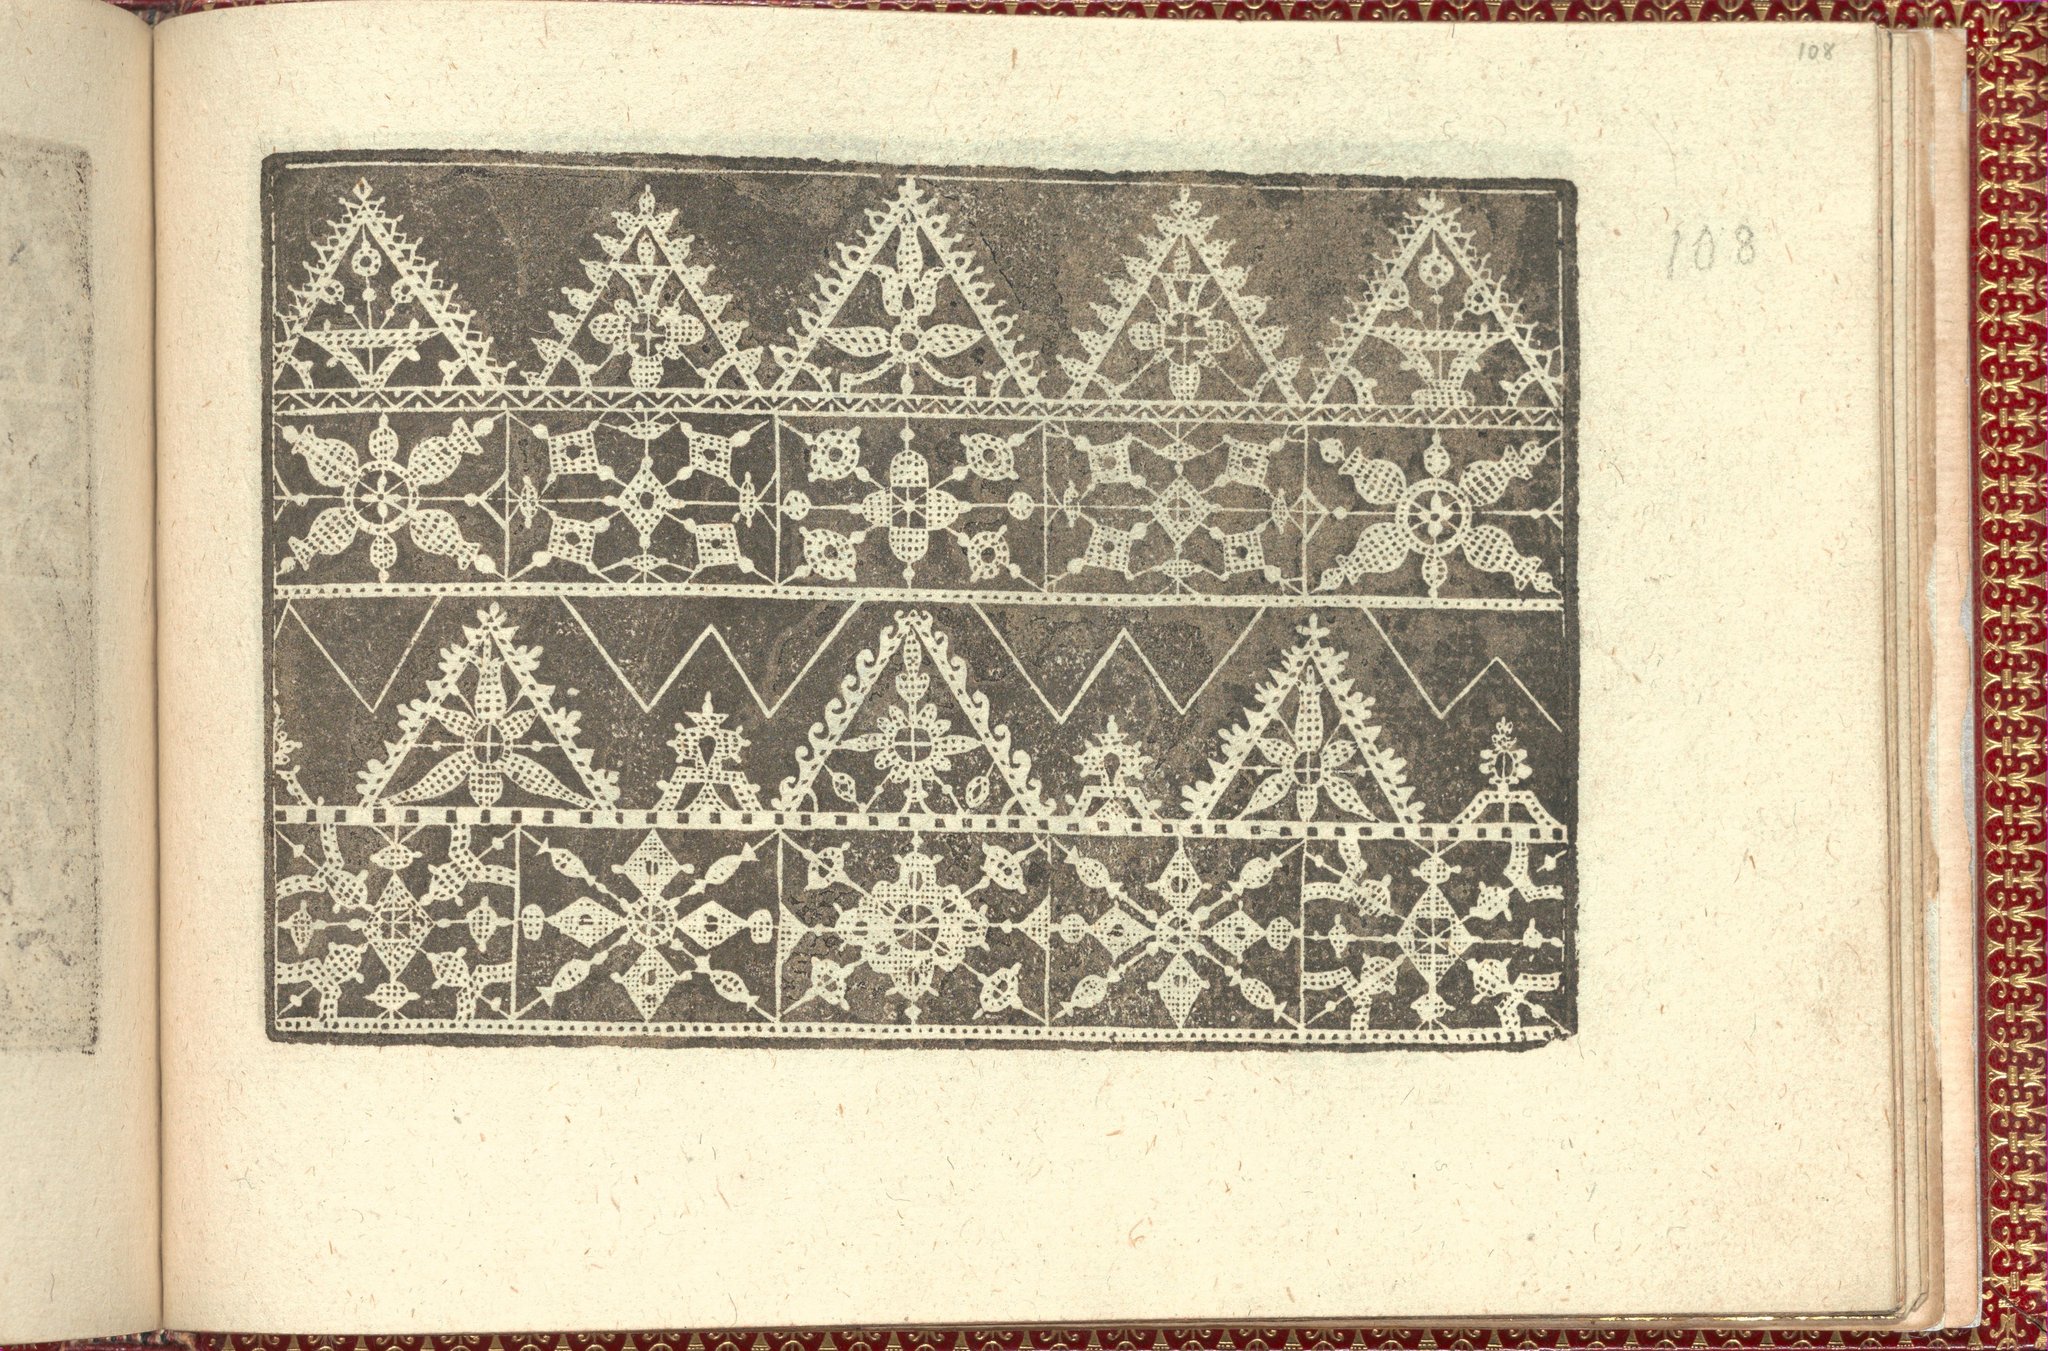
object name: book print ornament architecture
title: Corona delle Nobili et Virtuose Donne: Libro I-IV, page 108 (recto)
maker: cesare vecellio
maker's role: publisher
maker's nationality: italian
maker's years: 1521-1601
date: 1601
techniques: woodcut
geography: italy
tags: ornament